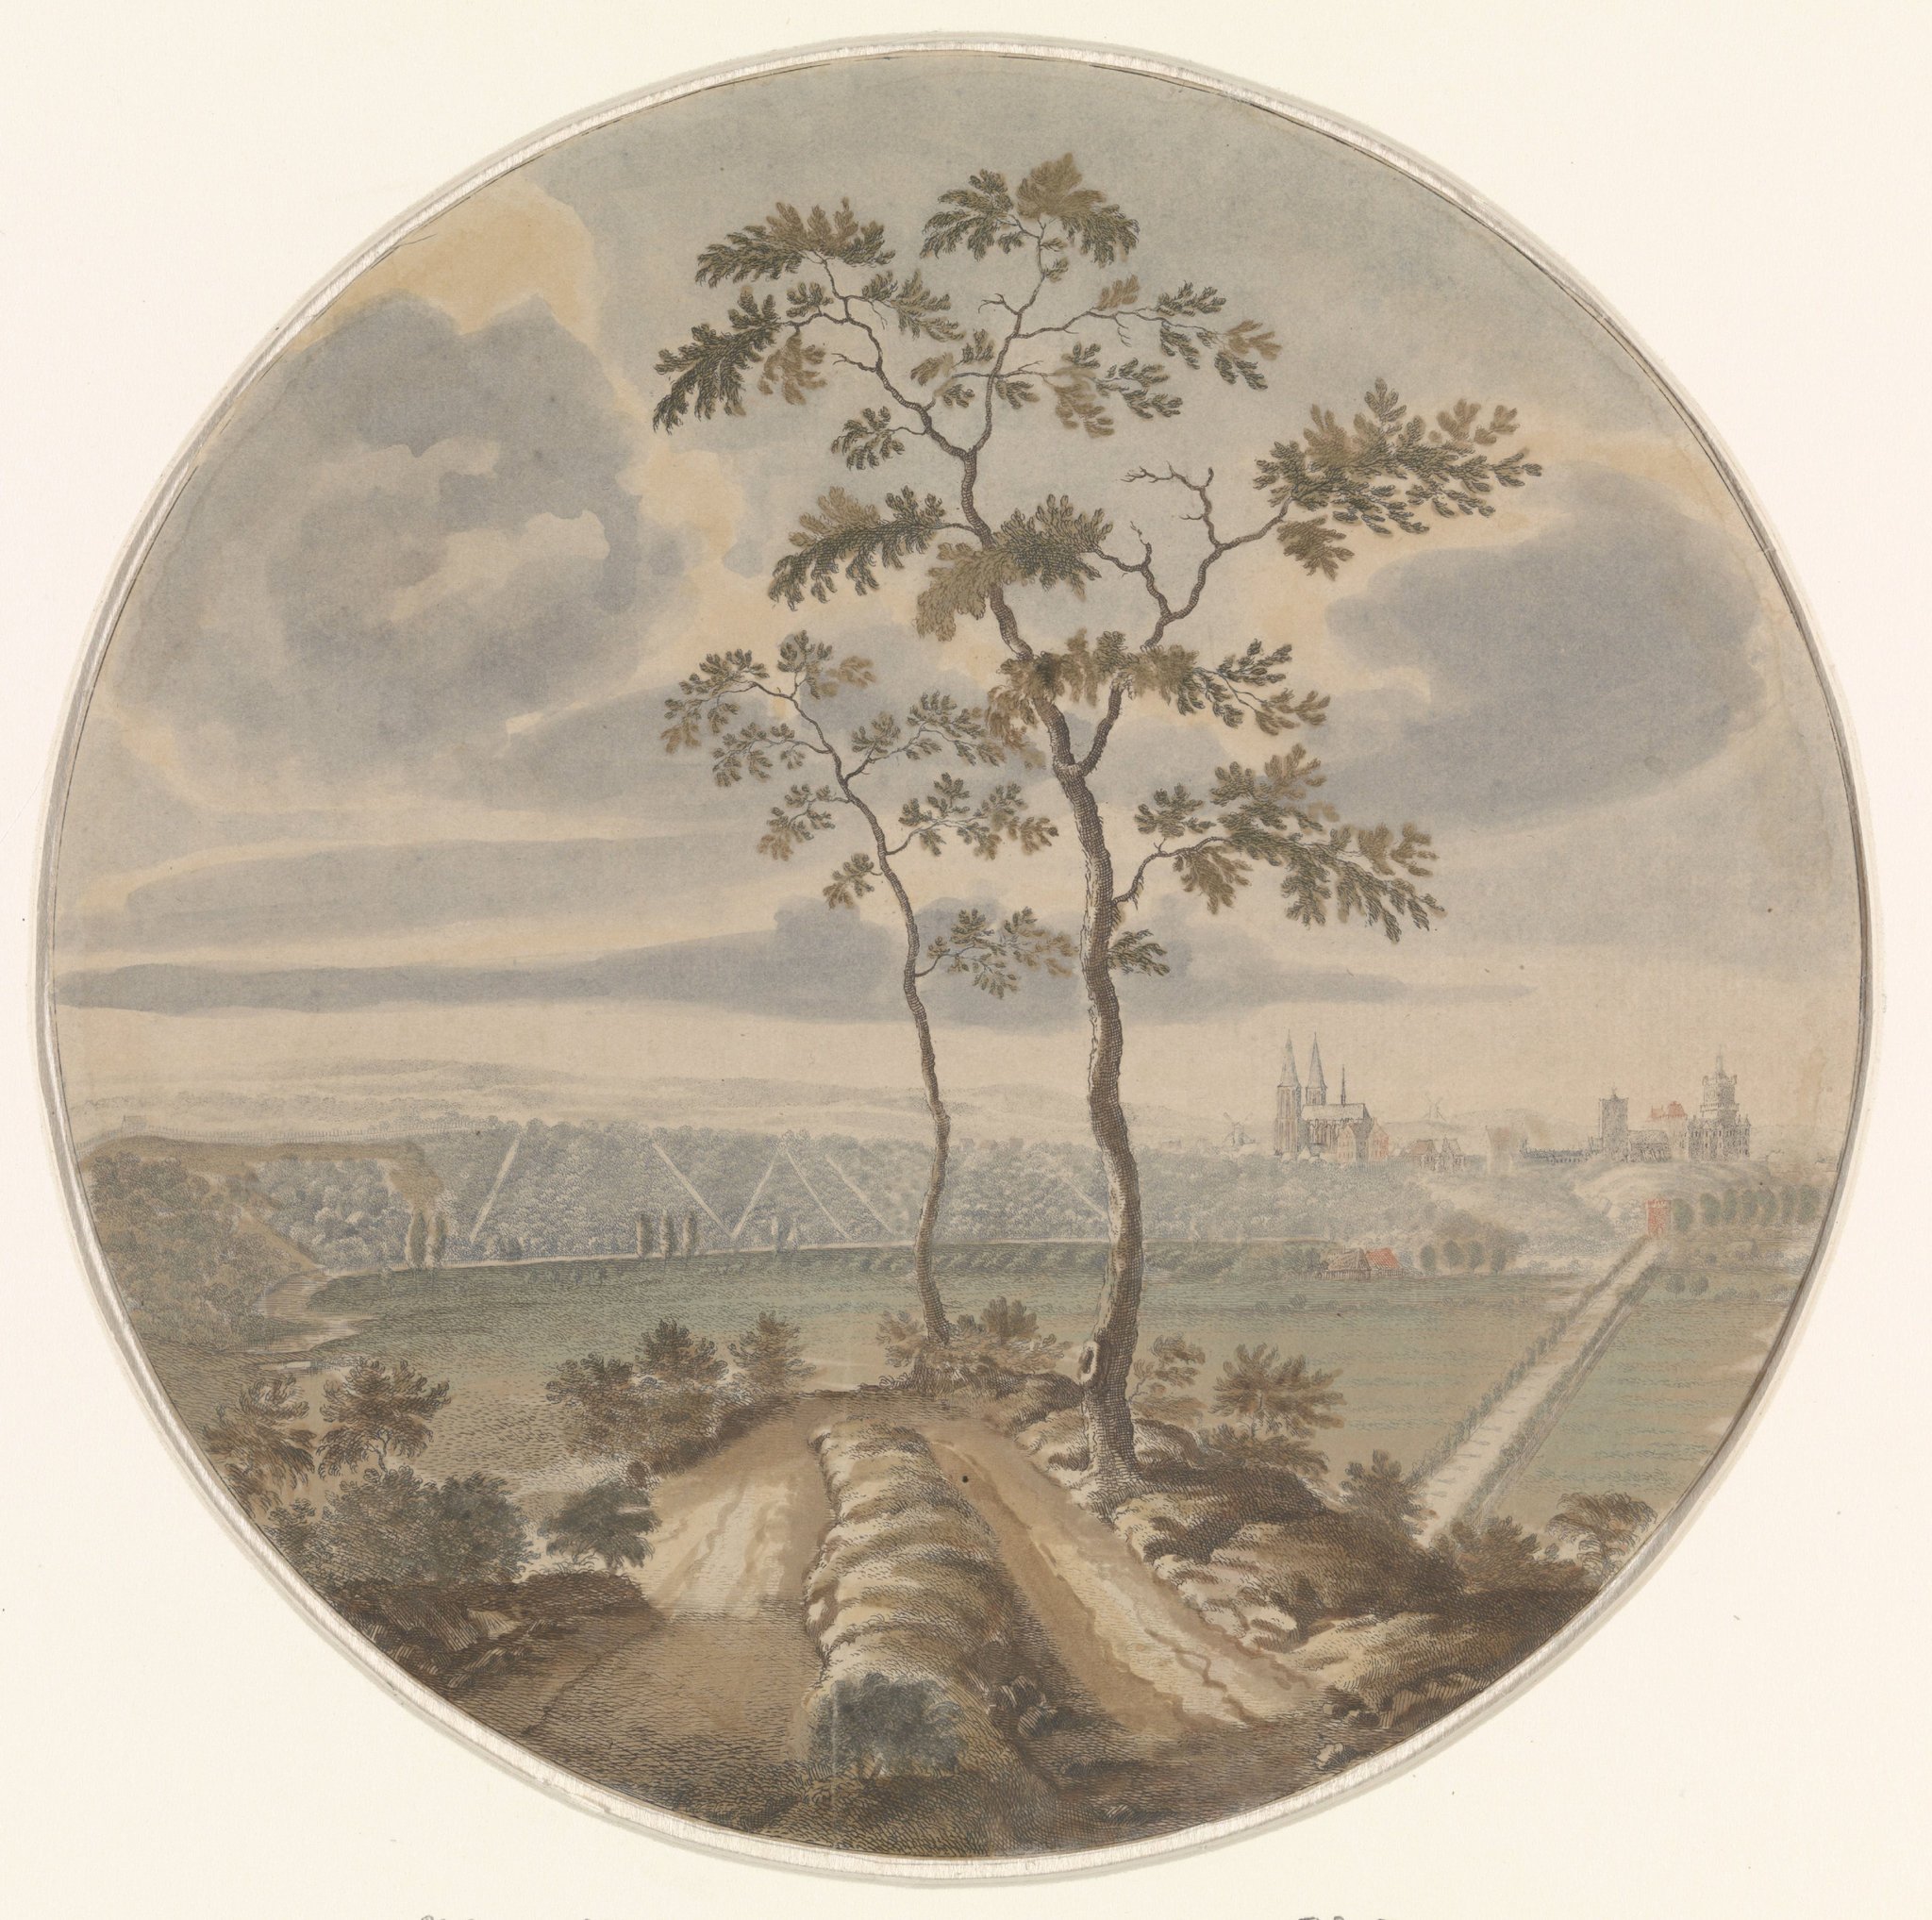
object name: print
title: Gezicht op de stad Kleef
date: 1688-1698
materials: paper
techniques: etching, hand coloring, lithography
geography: netherlands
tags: city-view, and landscape with man-made constructions, cleves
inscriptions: collector's mark: Lugt 2228, collector's mark: Lugt 2760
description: Landschap met een gezicht op de stad Kleef. Op de voorgrond twee bomen.